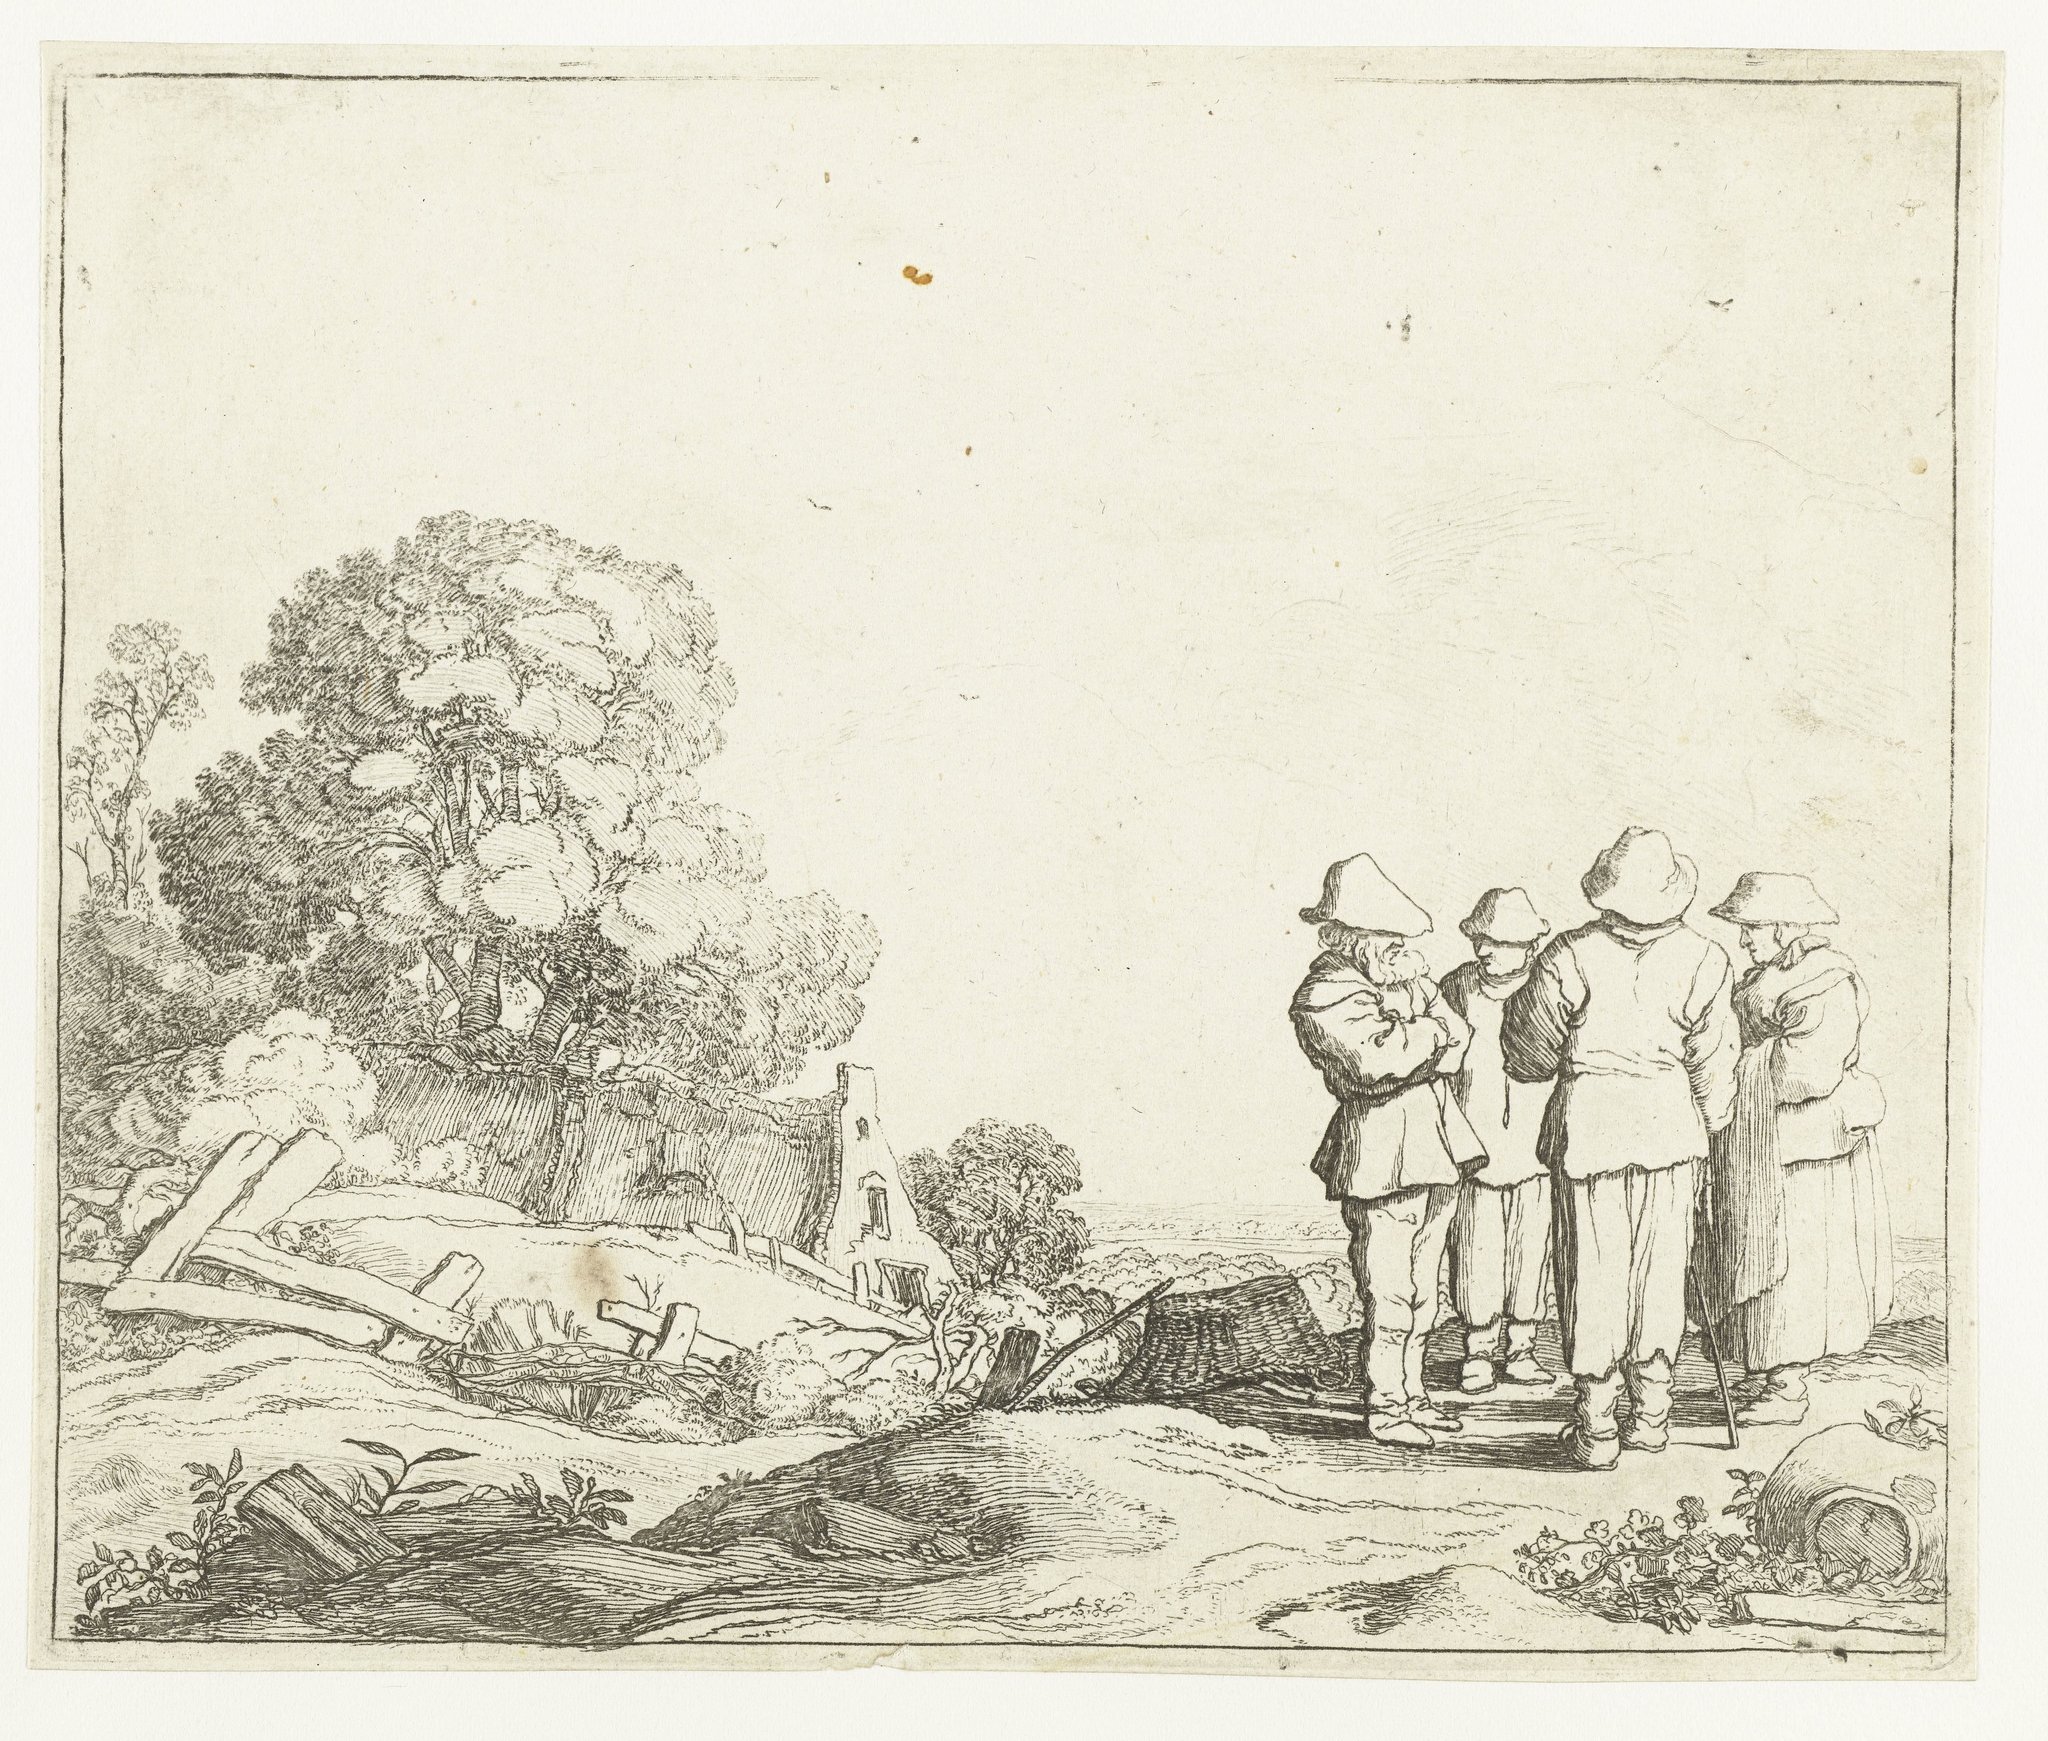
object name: print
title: Landschappen met figuren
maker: pieter de molijn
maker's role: draughtsman, painter, print maker, publisher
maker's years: 1595-1661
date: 1626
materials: paper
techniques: etching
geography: haarlem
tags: landscapes in the temperate zone, farmers, farm or solitary house in landscape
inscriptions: collector's mark: Lugt 2228a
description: In een landelijke omgeving staan drie boeren en een boerin in de buurt van een huis te praten. Bovenin de voorstelling is het tablet met het adres van de prentmaker (zie eerste staat) weggevaagd. Deze prent is onderdeel van een serie van vier prenten van landschappen met figuren.